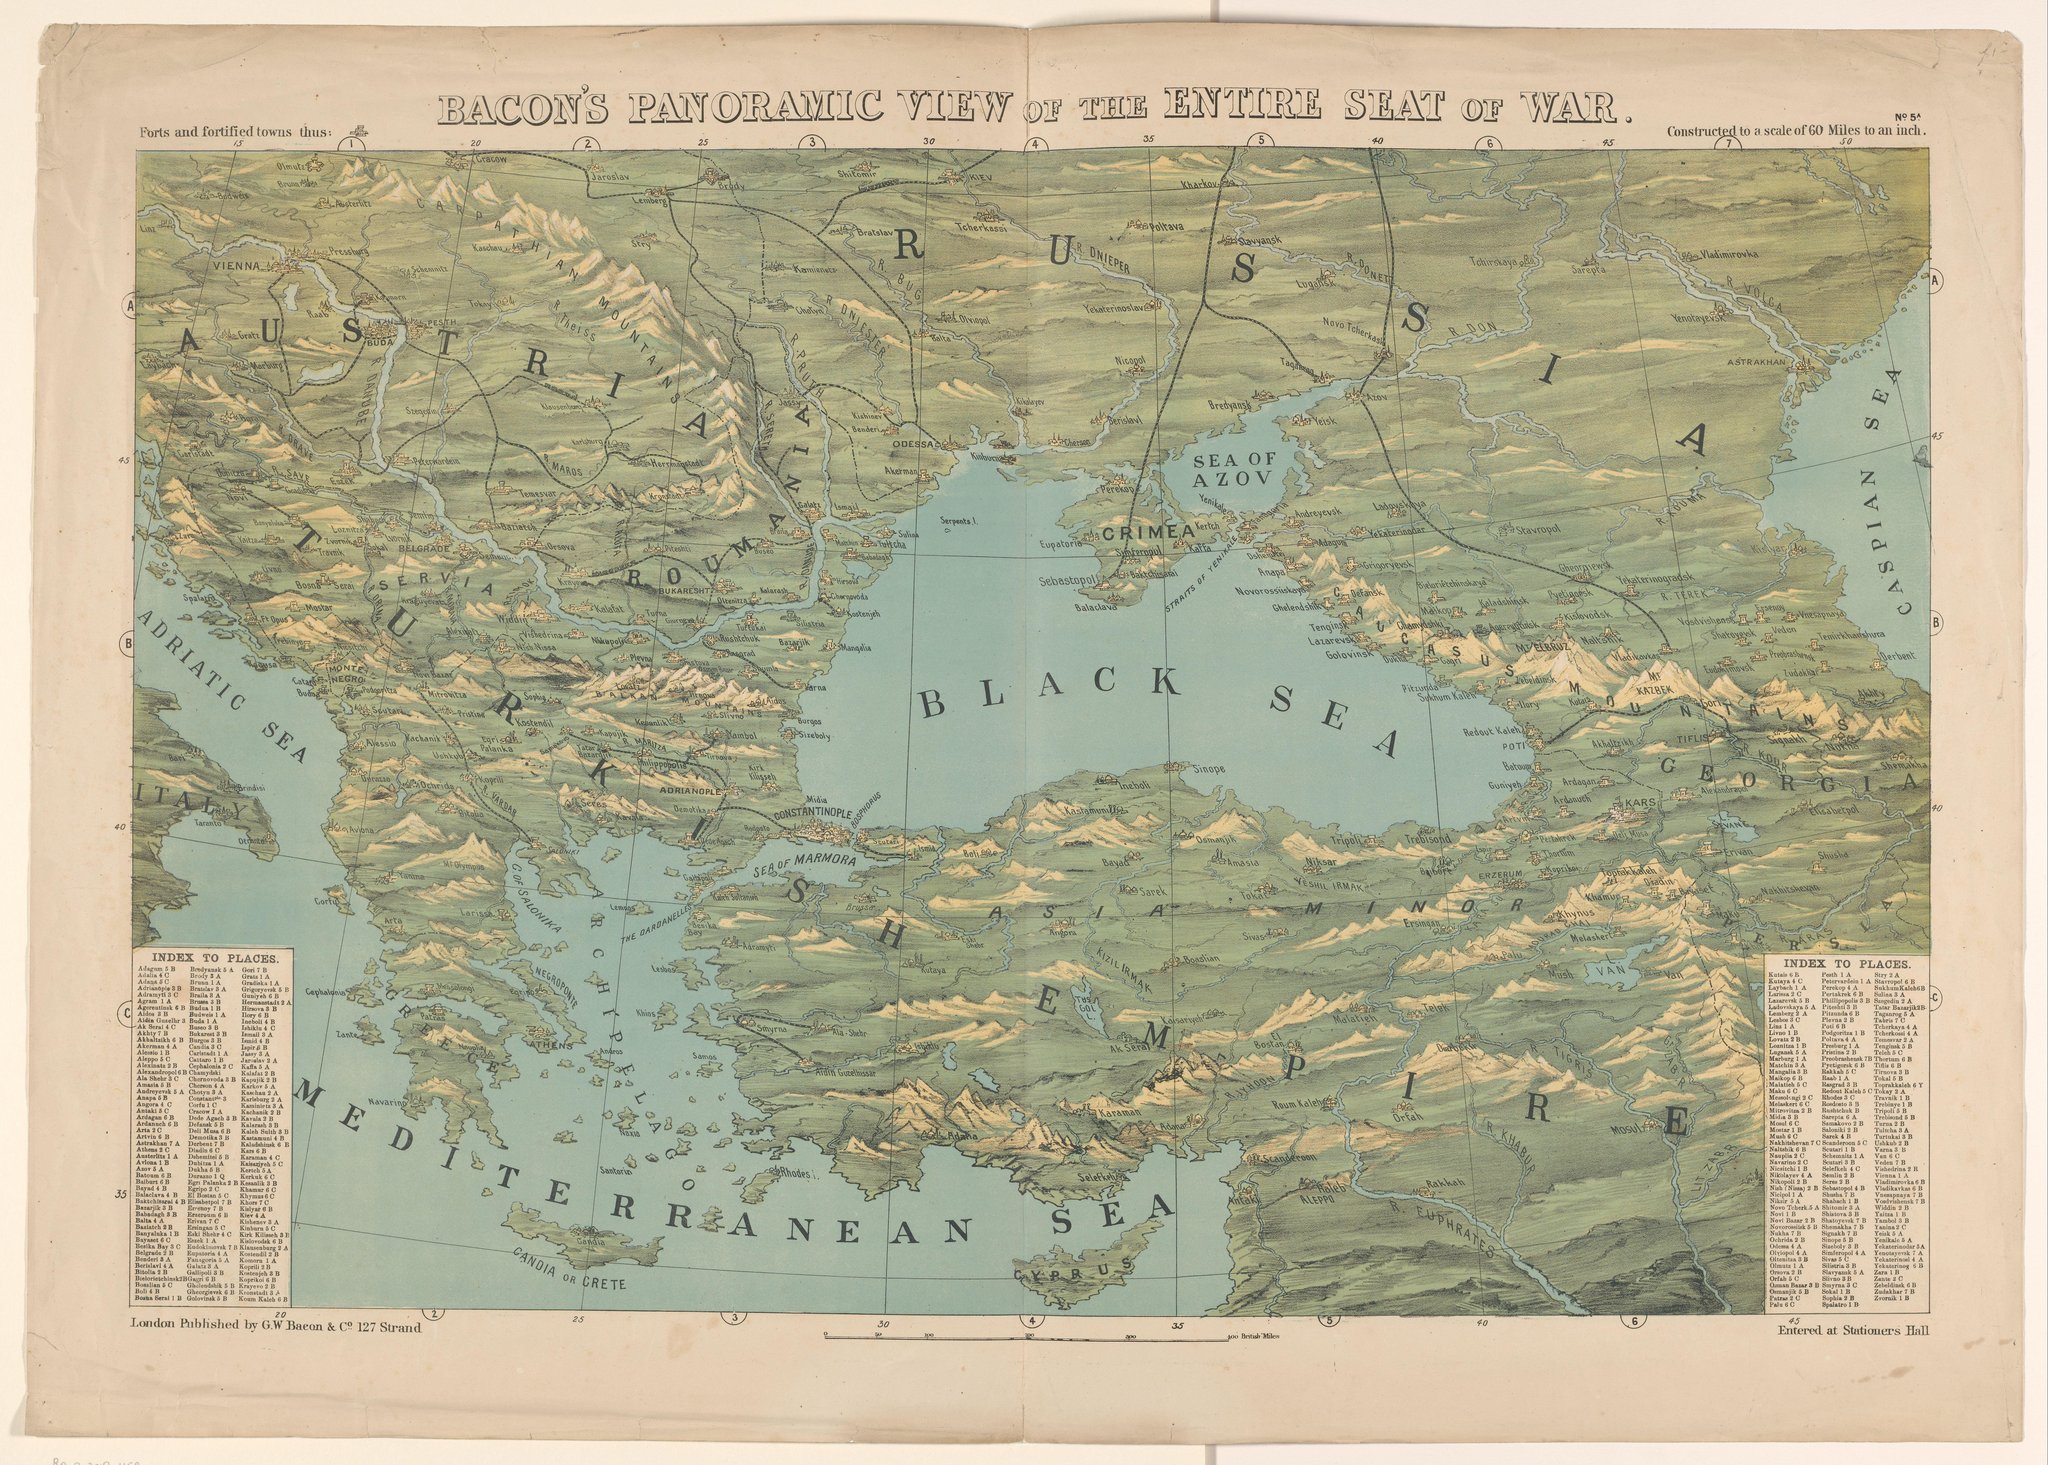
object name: print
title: Kaart van Griekenland en Klein-Azië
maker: Anonymous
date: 1853-1854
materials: paper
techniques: lithograph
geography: amsterdam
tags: maps of separate countries or regions, war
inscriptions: collector's mark: Lugt 2228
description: Kaart van Griekenland en Klein-Azië tijdens de Krimoorlog.